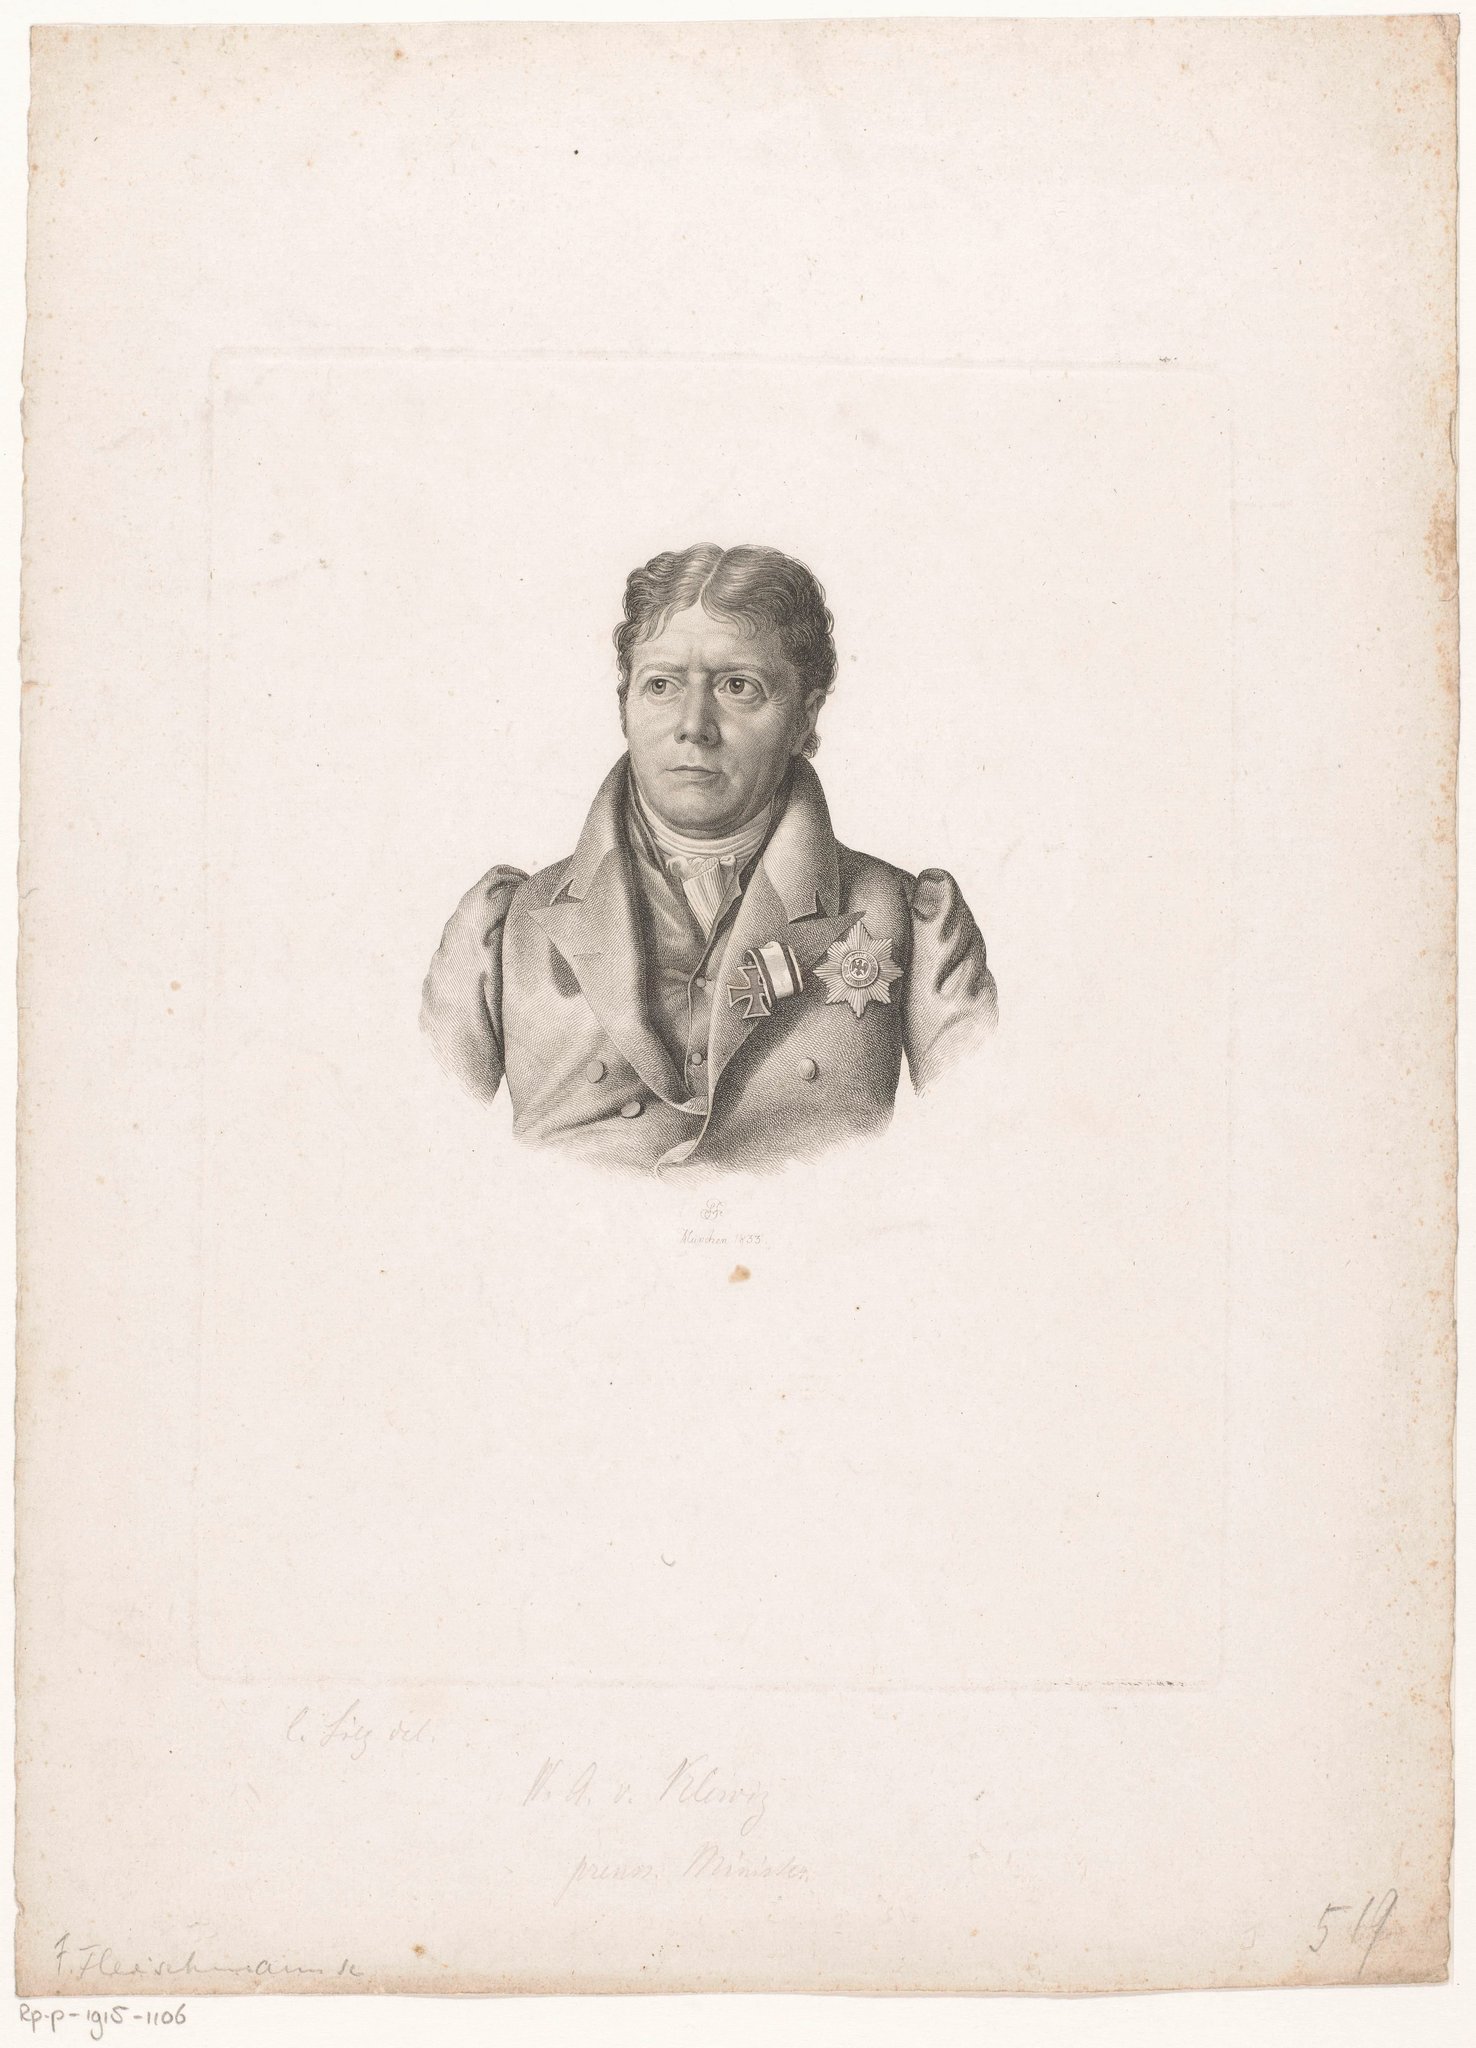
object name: print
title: Portret van Wilhelm Anton Klewitz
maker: friedrich fleischmann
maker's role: print maker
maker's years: 1791-1834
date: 1833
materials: paper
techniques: engraving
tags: knighthood order: teutonic order - insignia of a knighthood order, e.g.: badge, chain (with name of order), knighthood order (with name) - insignia of a knighthood order, e.g.: badge, chain (with name of order), historical persons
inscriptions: collector's mark: Lugt 2228